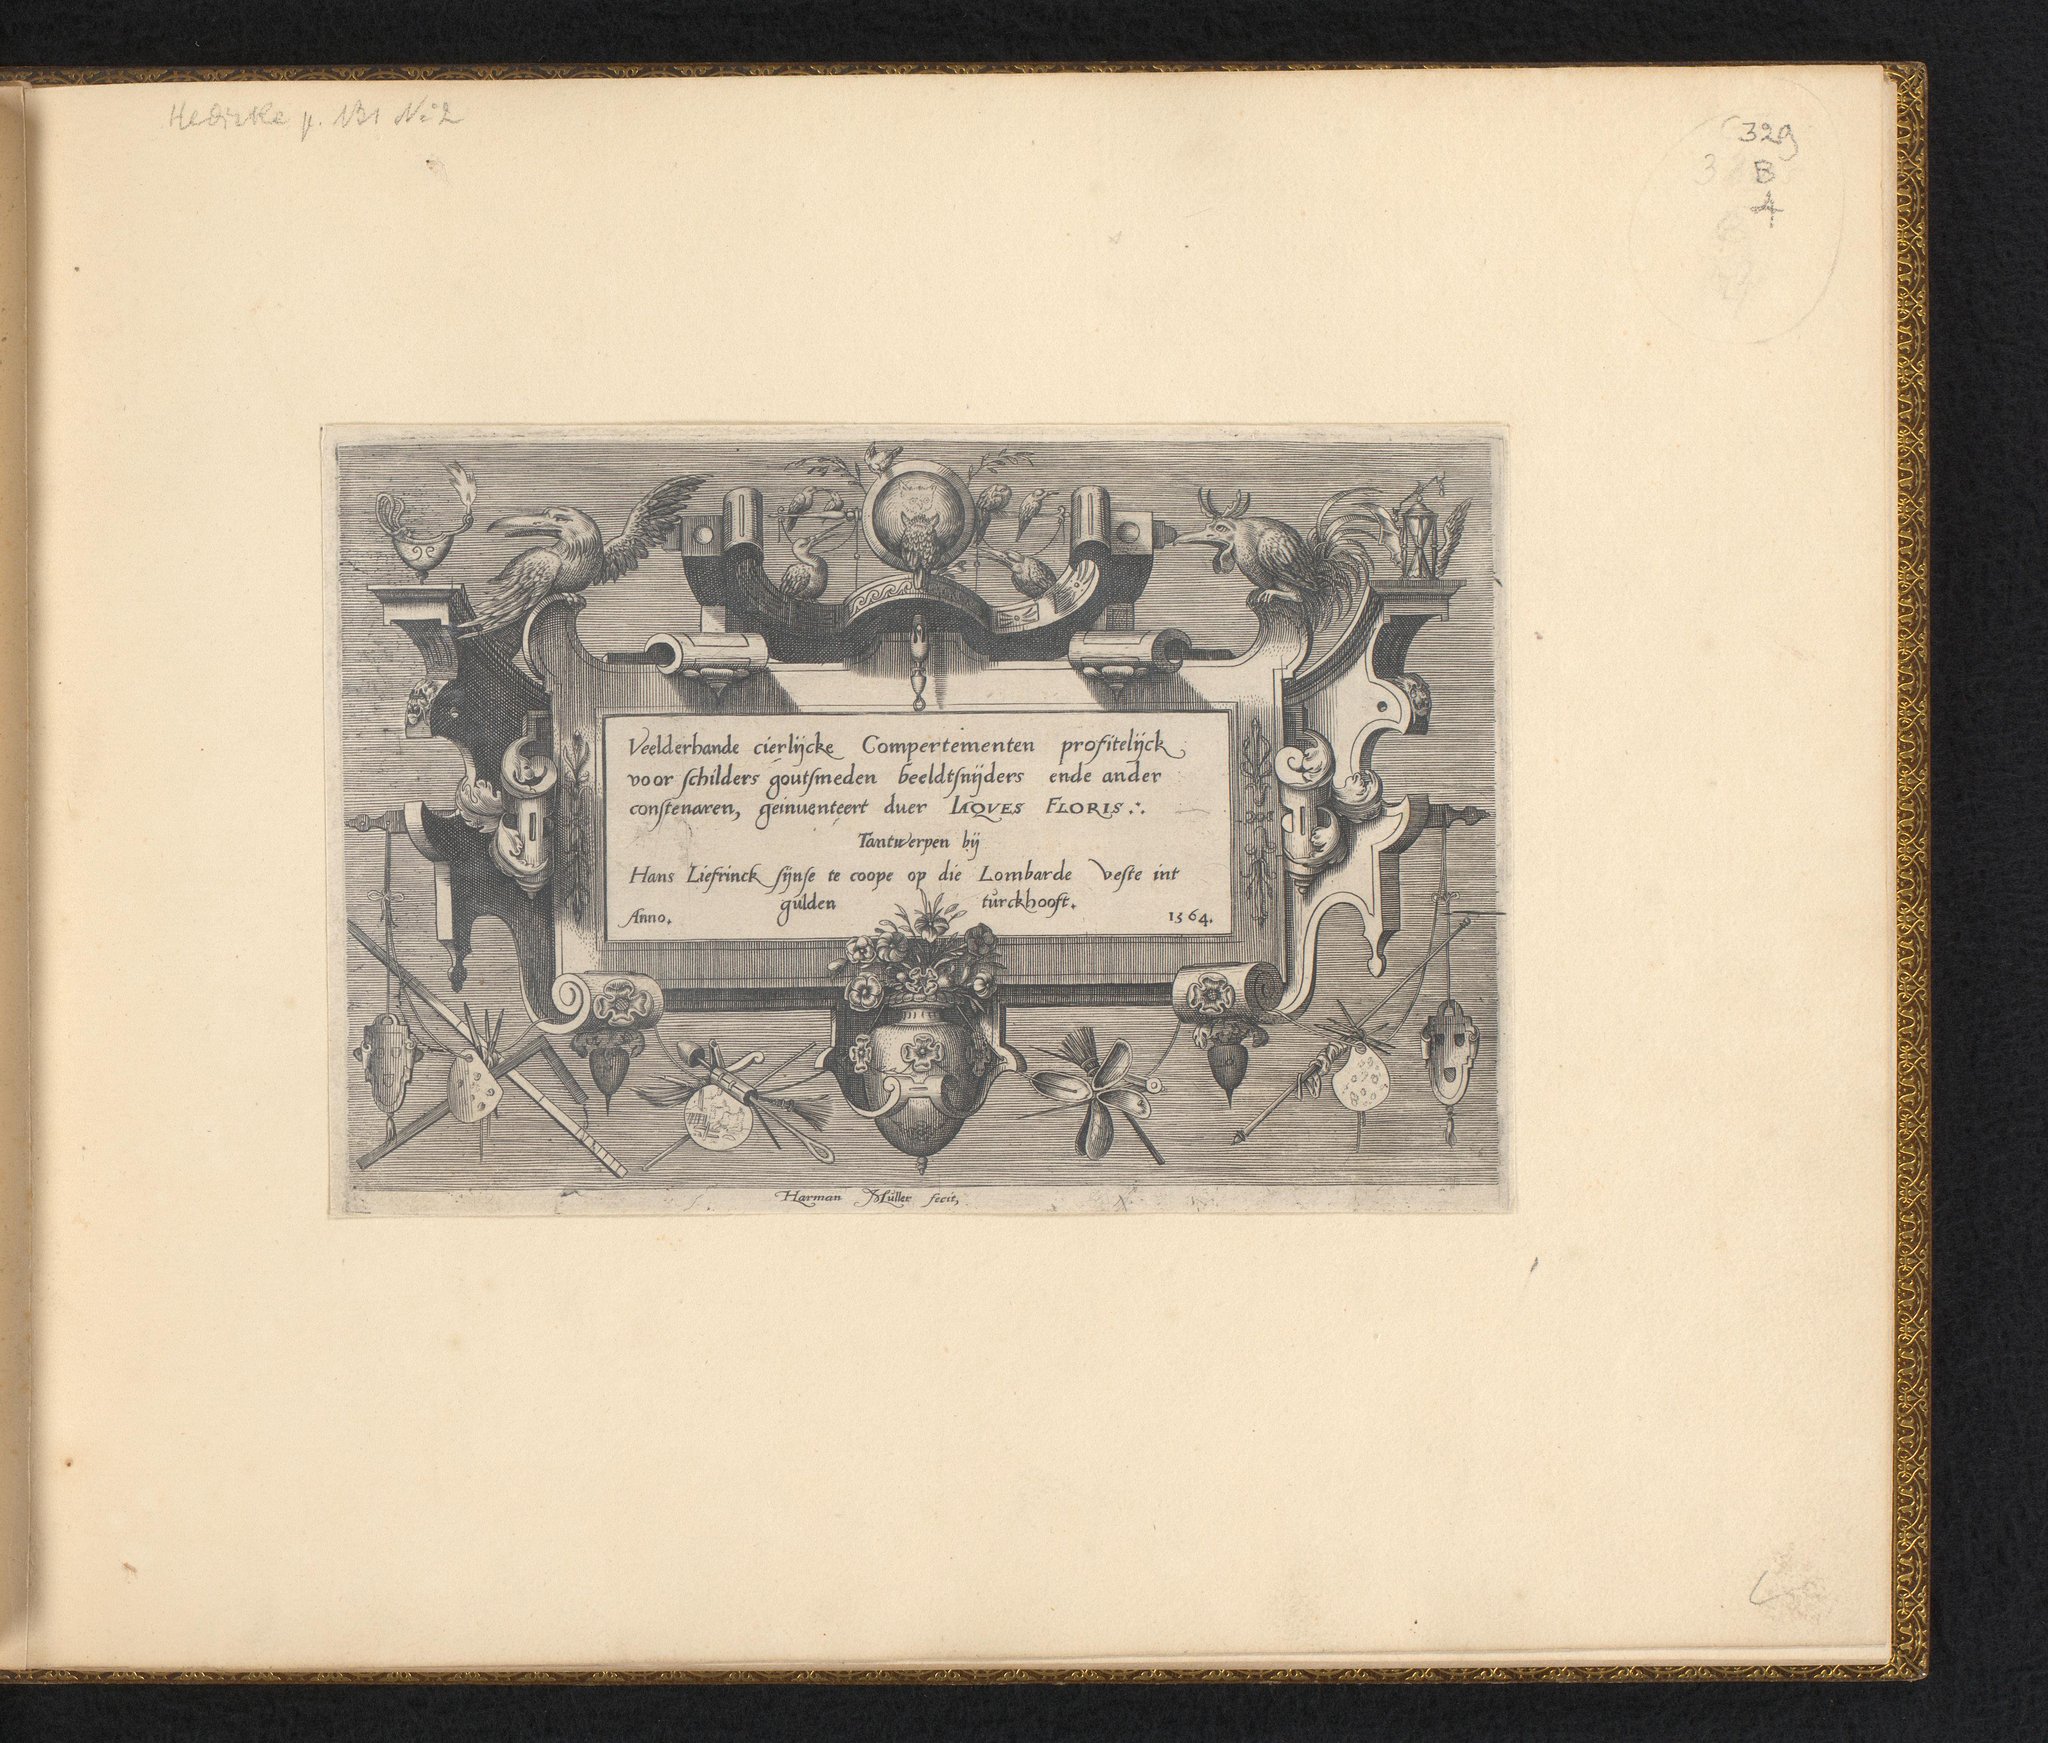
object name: print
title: Cartouche met een omlijsting van rolwerk, gedecoreerd met vogels en kunstenaarstrofeeën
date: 1564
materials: paper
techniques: engraving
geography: antwerp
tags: the arts; artists, trophy, i.e.: decorative arrangement of symbolic or typical objects ~ ornament, scrollwork, strapwork ~ ornament, birds, tools, implements of graphic artist, tools, implements of painter, hourglass, oil-lamp, ornament ~ cartouche, owls, reflection (in a mirror)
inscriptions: date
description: Titelprent met een cartouche in een omlijsting van rolwerk. In de bovenste helft van de voorstelling verschillende vogels. In het midden ziet een uil zichzelf in een spiegel. Linksboven een olielamp en rechtsboven een gevleugelde zandloper. In de onderste helft van de voorstelling trofeeën met attributen van goudsmeden, schilders, beeldsnijders etc. Midden onder een bloemenvaas. De prent maakt deel uit van een album.